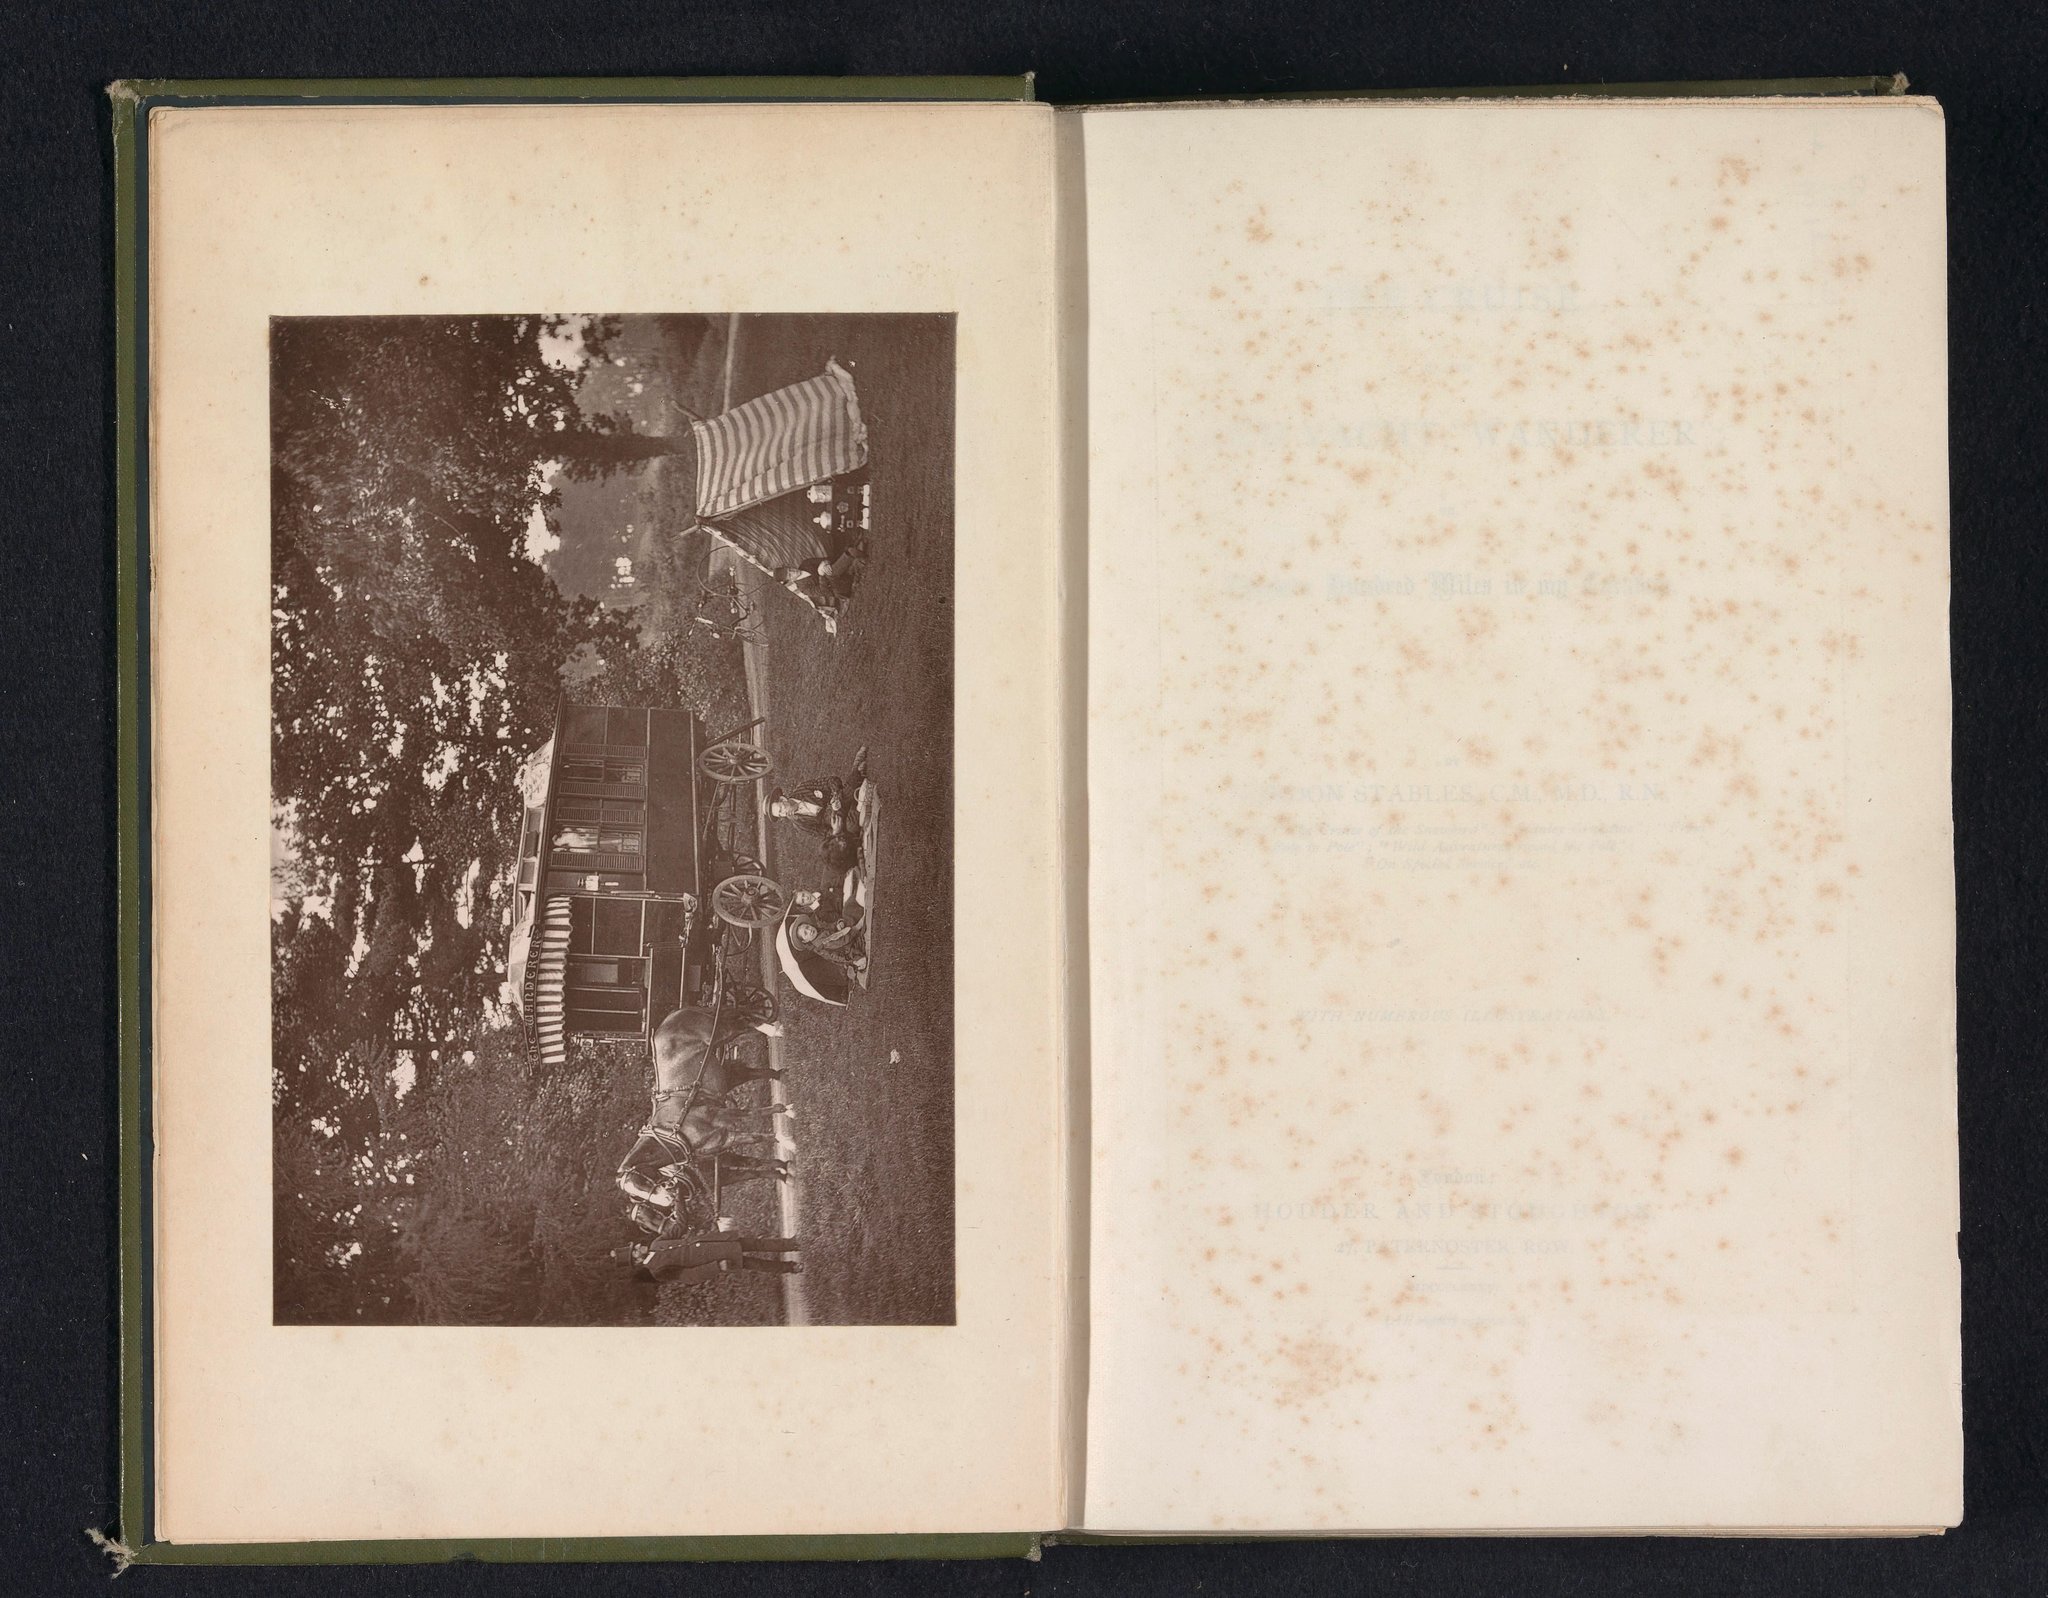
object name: page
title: Gezicht op een woonwagen met ervoor twee paarden en op en grasveld een man en drie kinderen op een kleed en bij een tent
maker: Anonymous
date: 1876-1886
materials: paper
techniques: woodburytype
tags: tent, caravan (trailer), horse